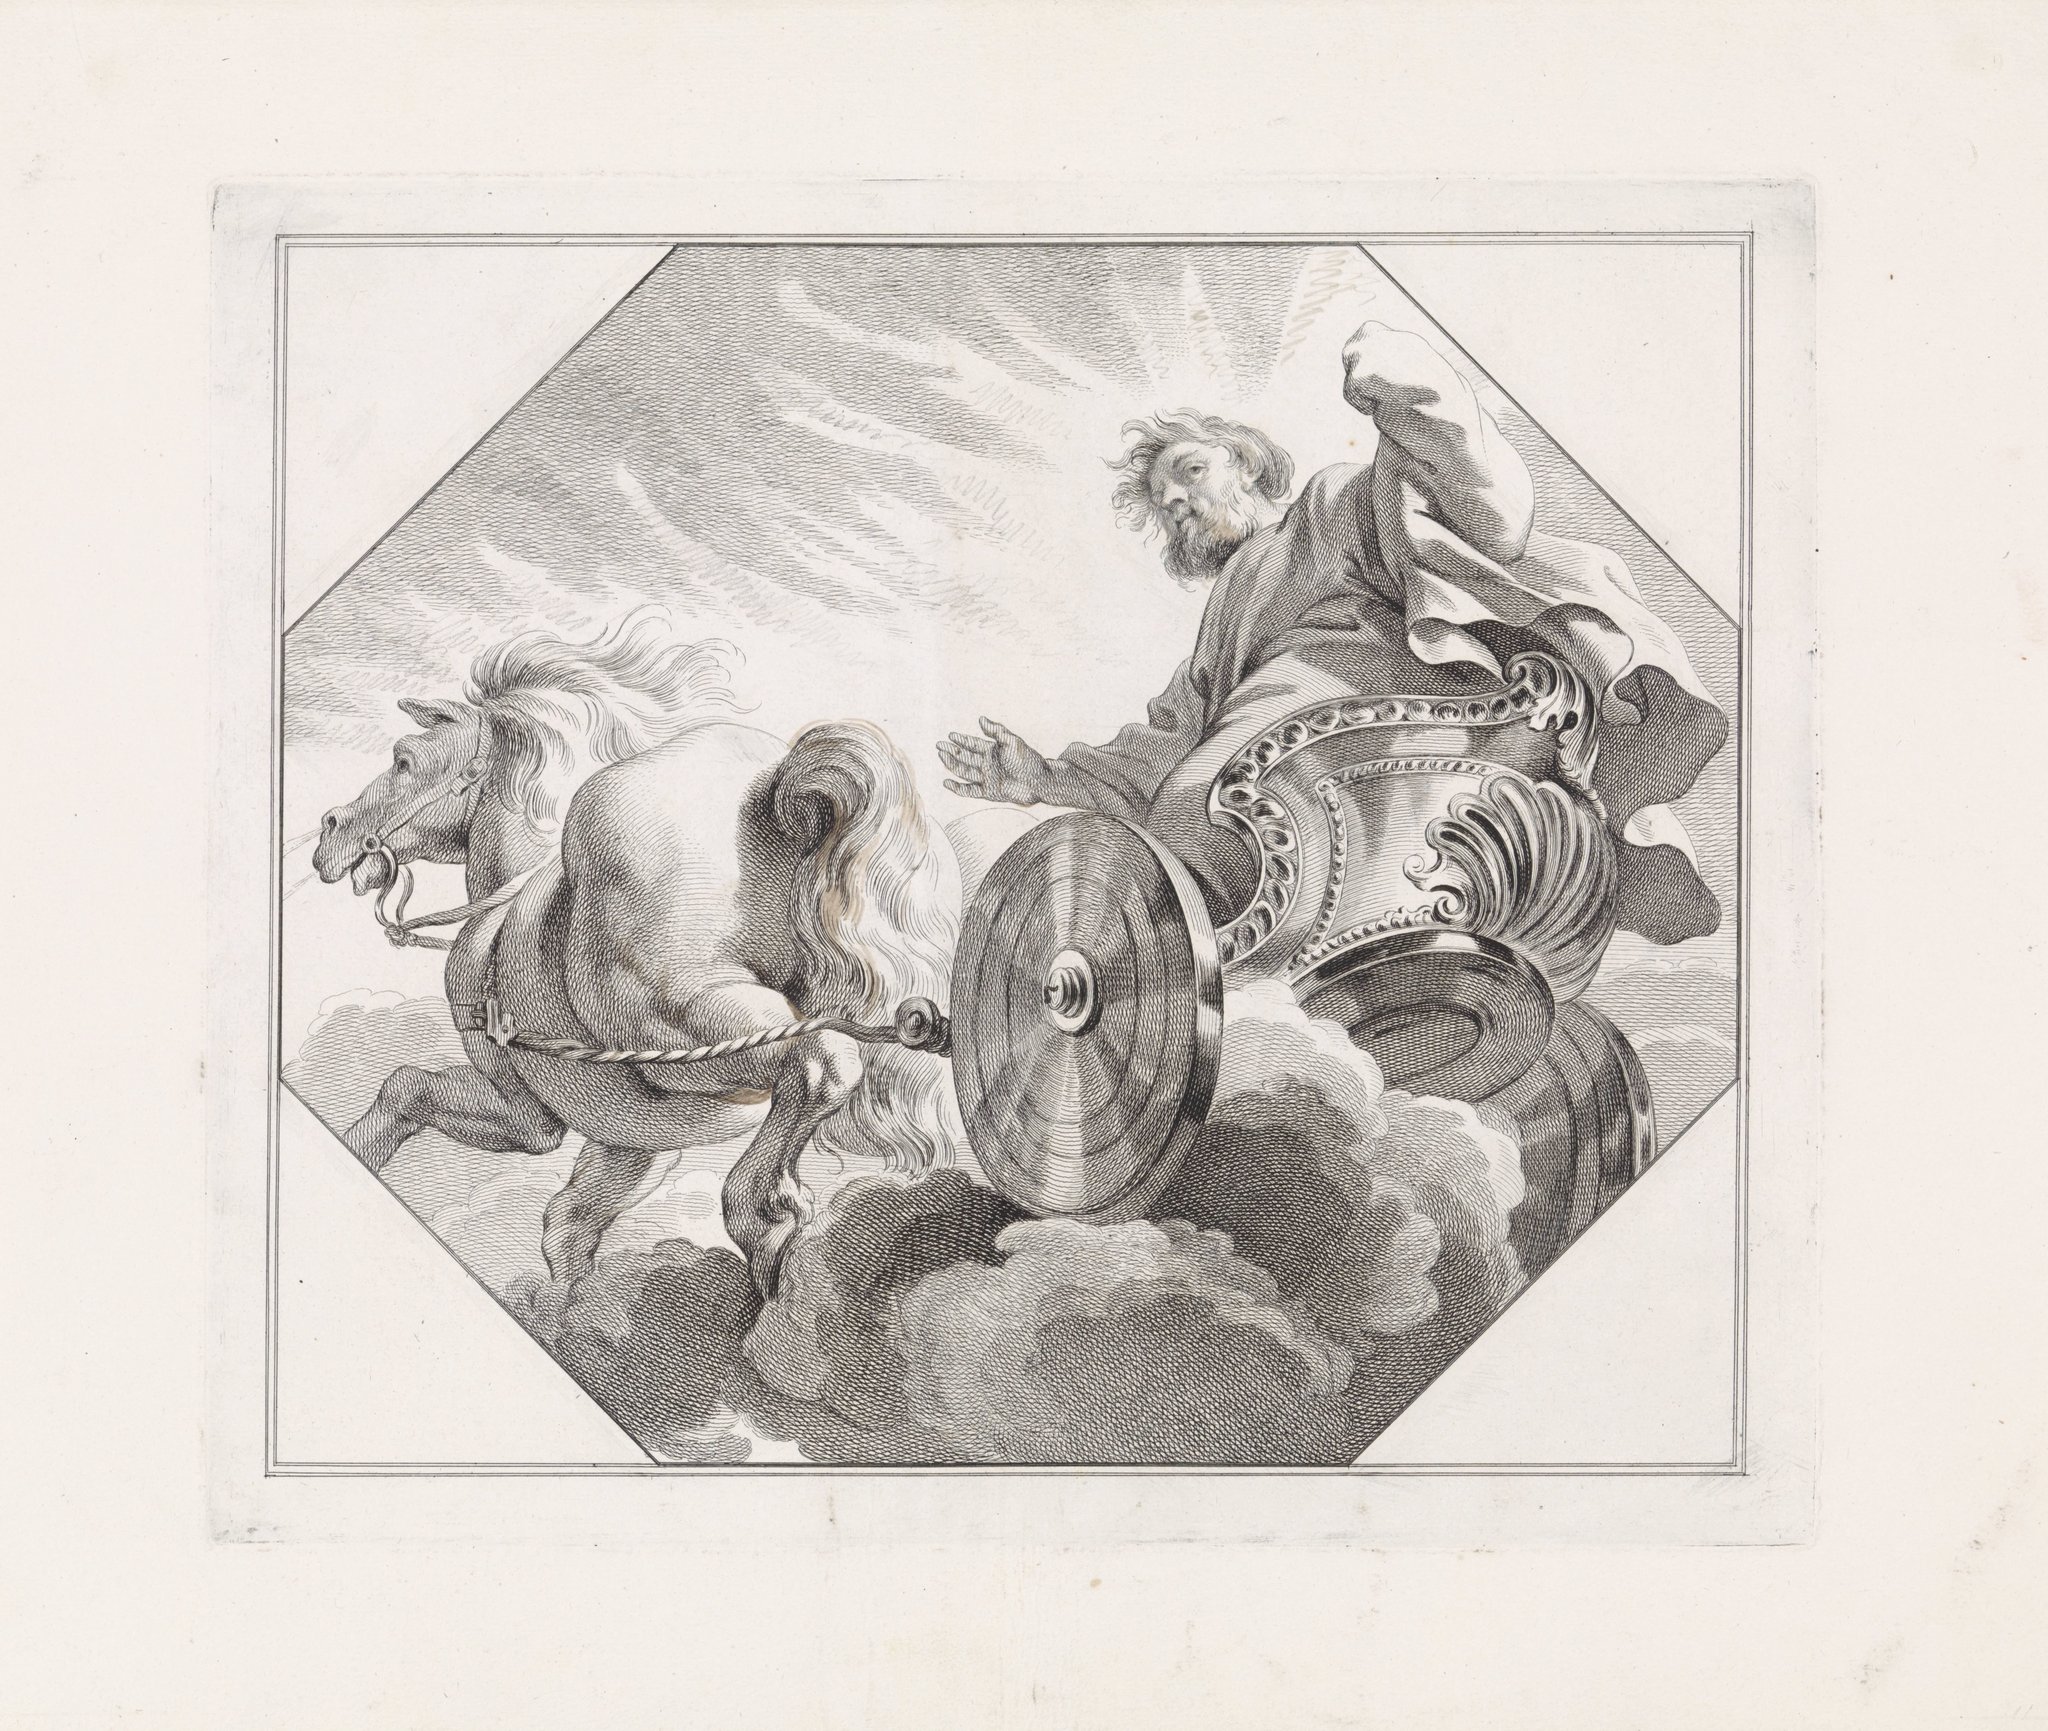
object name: print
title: Hemelvaart van Elia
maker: jan punt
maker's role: draughtsman, print maker, publisher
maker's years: 1711-1779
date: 1750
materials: paper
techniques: engraving, etching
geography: amsterdam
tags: a chariot, horses of fire and a whirlwind appear and elijah is carried up into heaven; elijah's cloak falls (or he hands it over to elisha)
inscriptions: collector's mark: Lugt 240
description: Elia in een wagen getrokken door een paard in de wolken.